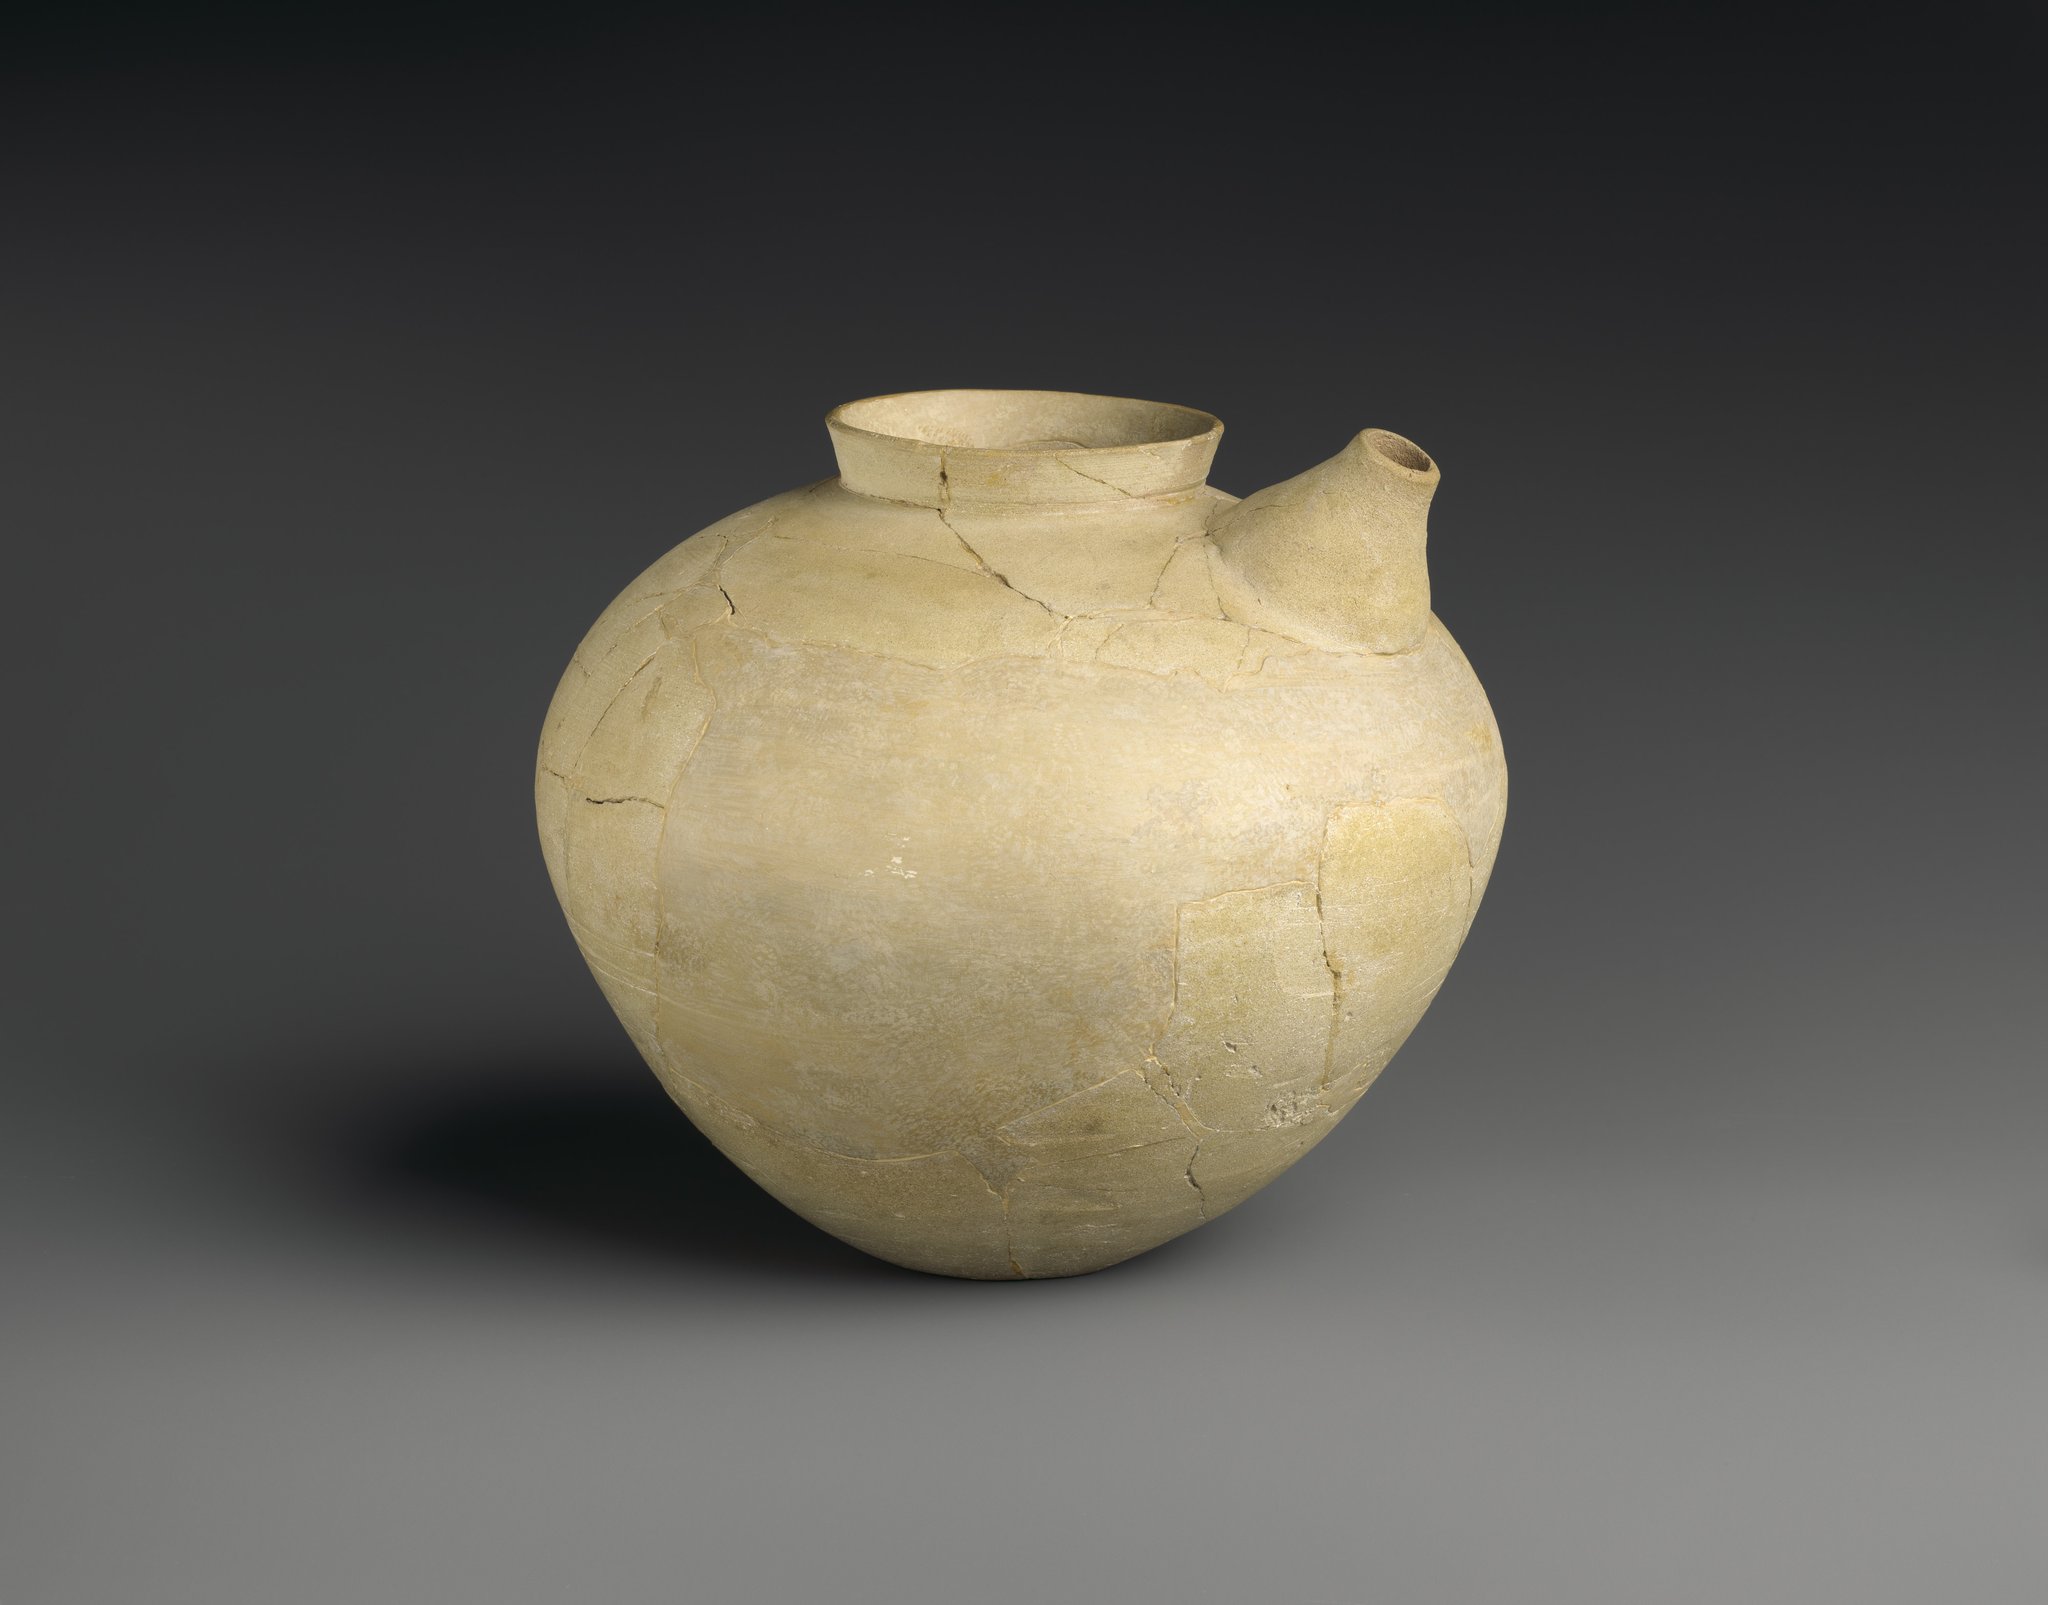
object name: jar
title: Spouted jar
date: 4000-3001 BCE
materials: ceramic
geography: mesopotamia